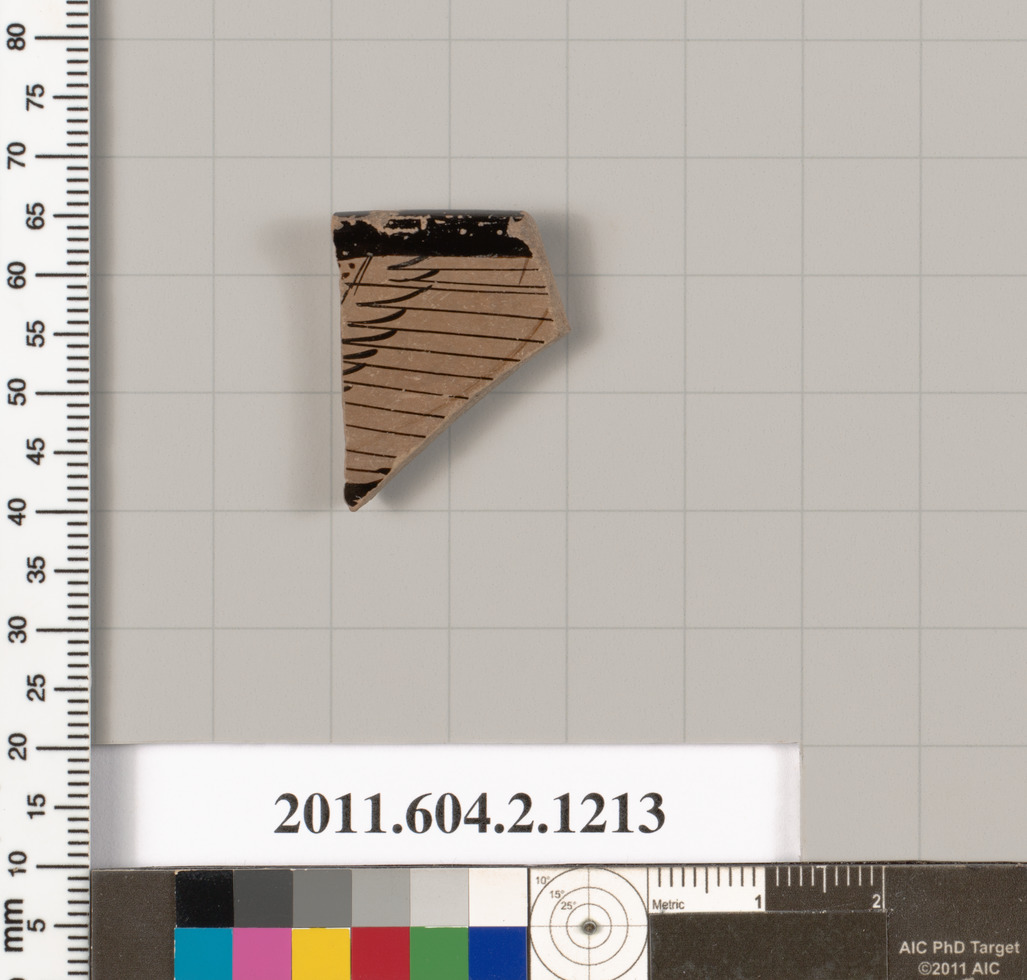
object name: kantharos fragment, head vase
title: Terracotta fragment from a kantharos: head vase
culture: greek, attic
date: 475-451 BCE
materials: terracotta